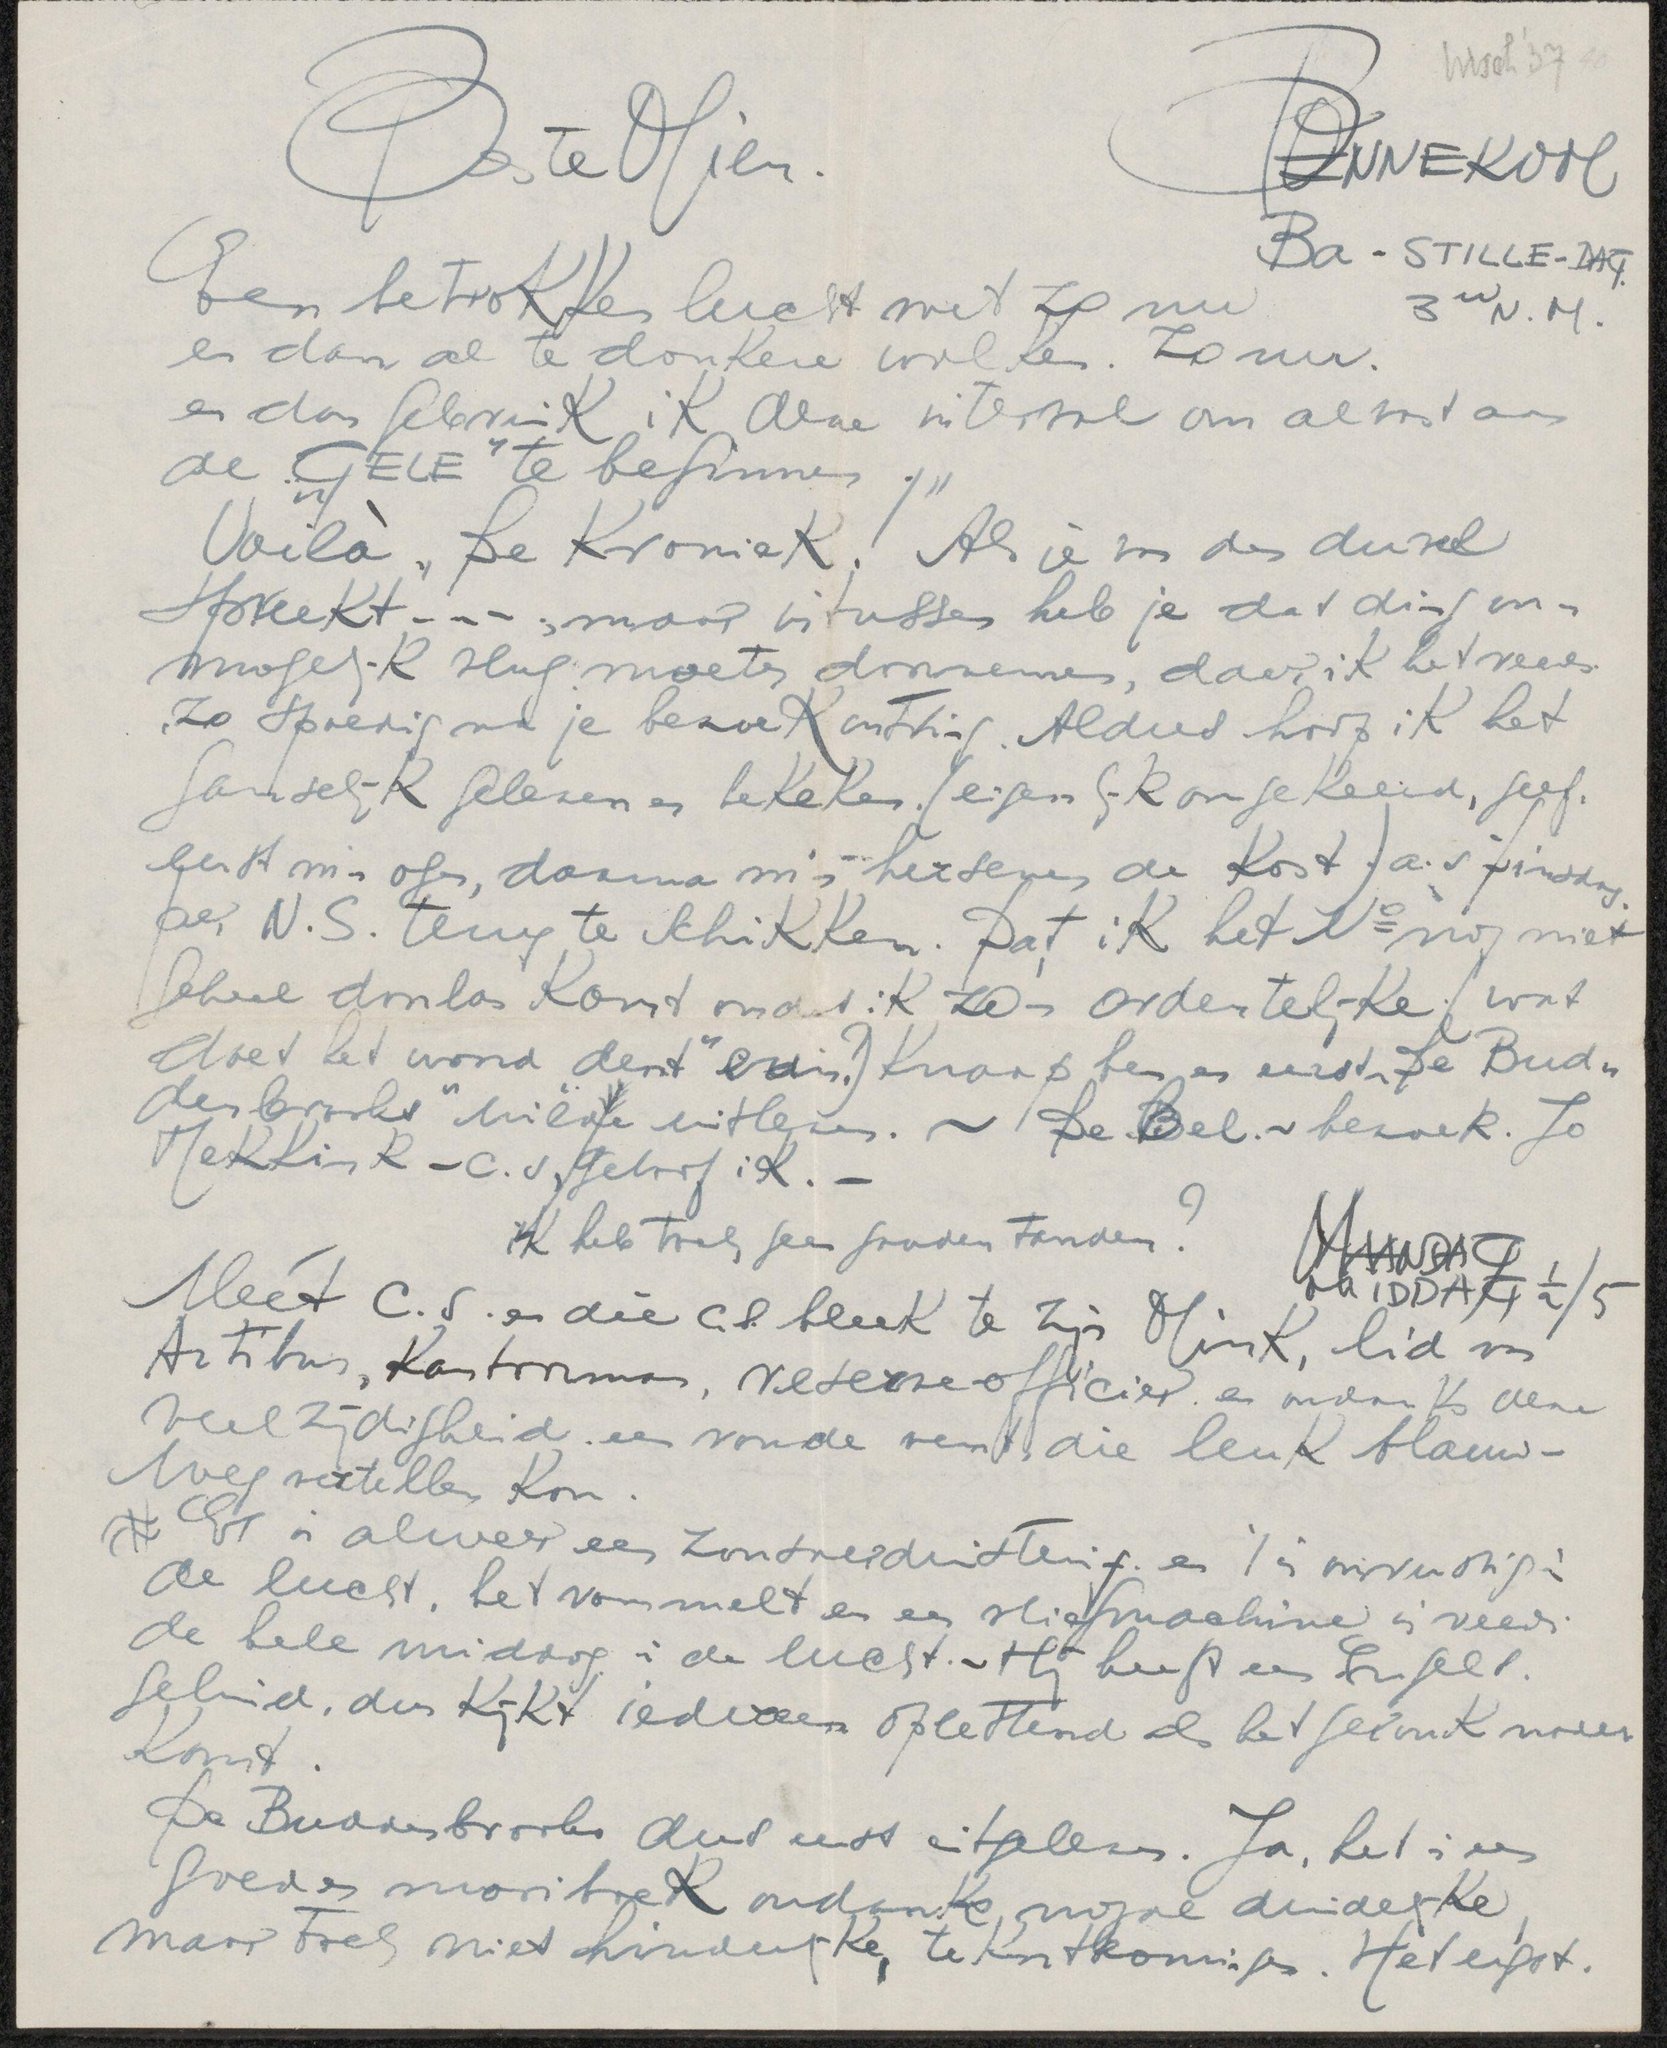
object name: letter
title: Brief aan Mien Cambier van Nooten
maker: dick ket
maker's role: draughtsman, print maker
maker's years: 1902-1940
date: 1912-1940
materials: ink, paper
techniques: pen, writing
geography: bennekom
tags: print maker, draughtsman, mien cambier van nooten, literature ~ arts, painting (including book-illumination, miniature-painting), diseases, rotterdam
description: Brief gedateerd 'Ba-STILLE-DAG' (14 juli) door schrijver, 'wrsch '37' in latere hand.